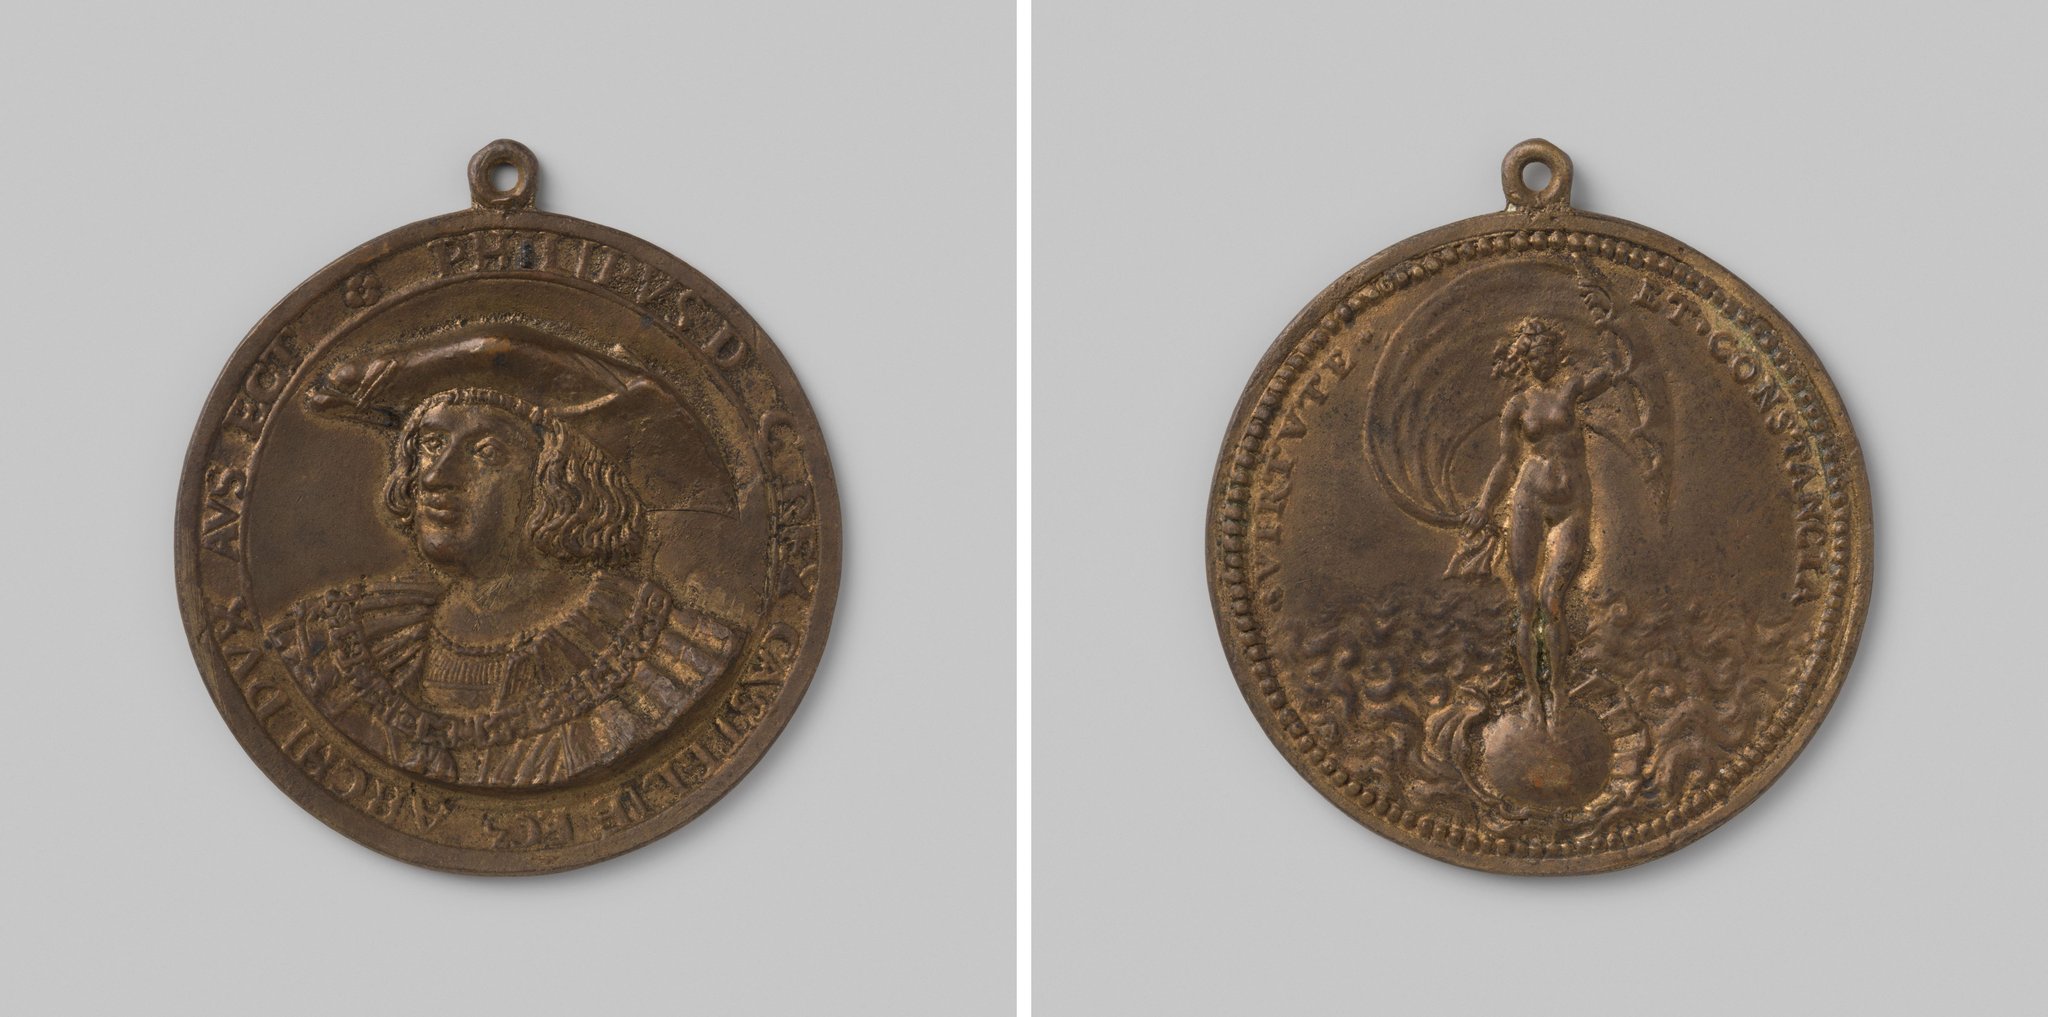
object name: history medal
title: Filips de Schone, koning van Spanje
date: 1505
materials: bronze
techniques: casting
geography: antwerp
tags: filips de schone (hertog van bourgondië)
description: Bronzen penning met draagoog. Voorzijde: borststuk man binnen omschrift. Keerzijde: Geluk met zeil boven haar hoofd, staande in een schelp binnen omschrift